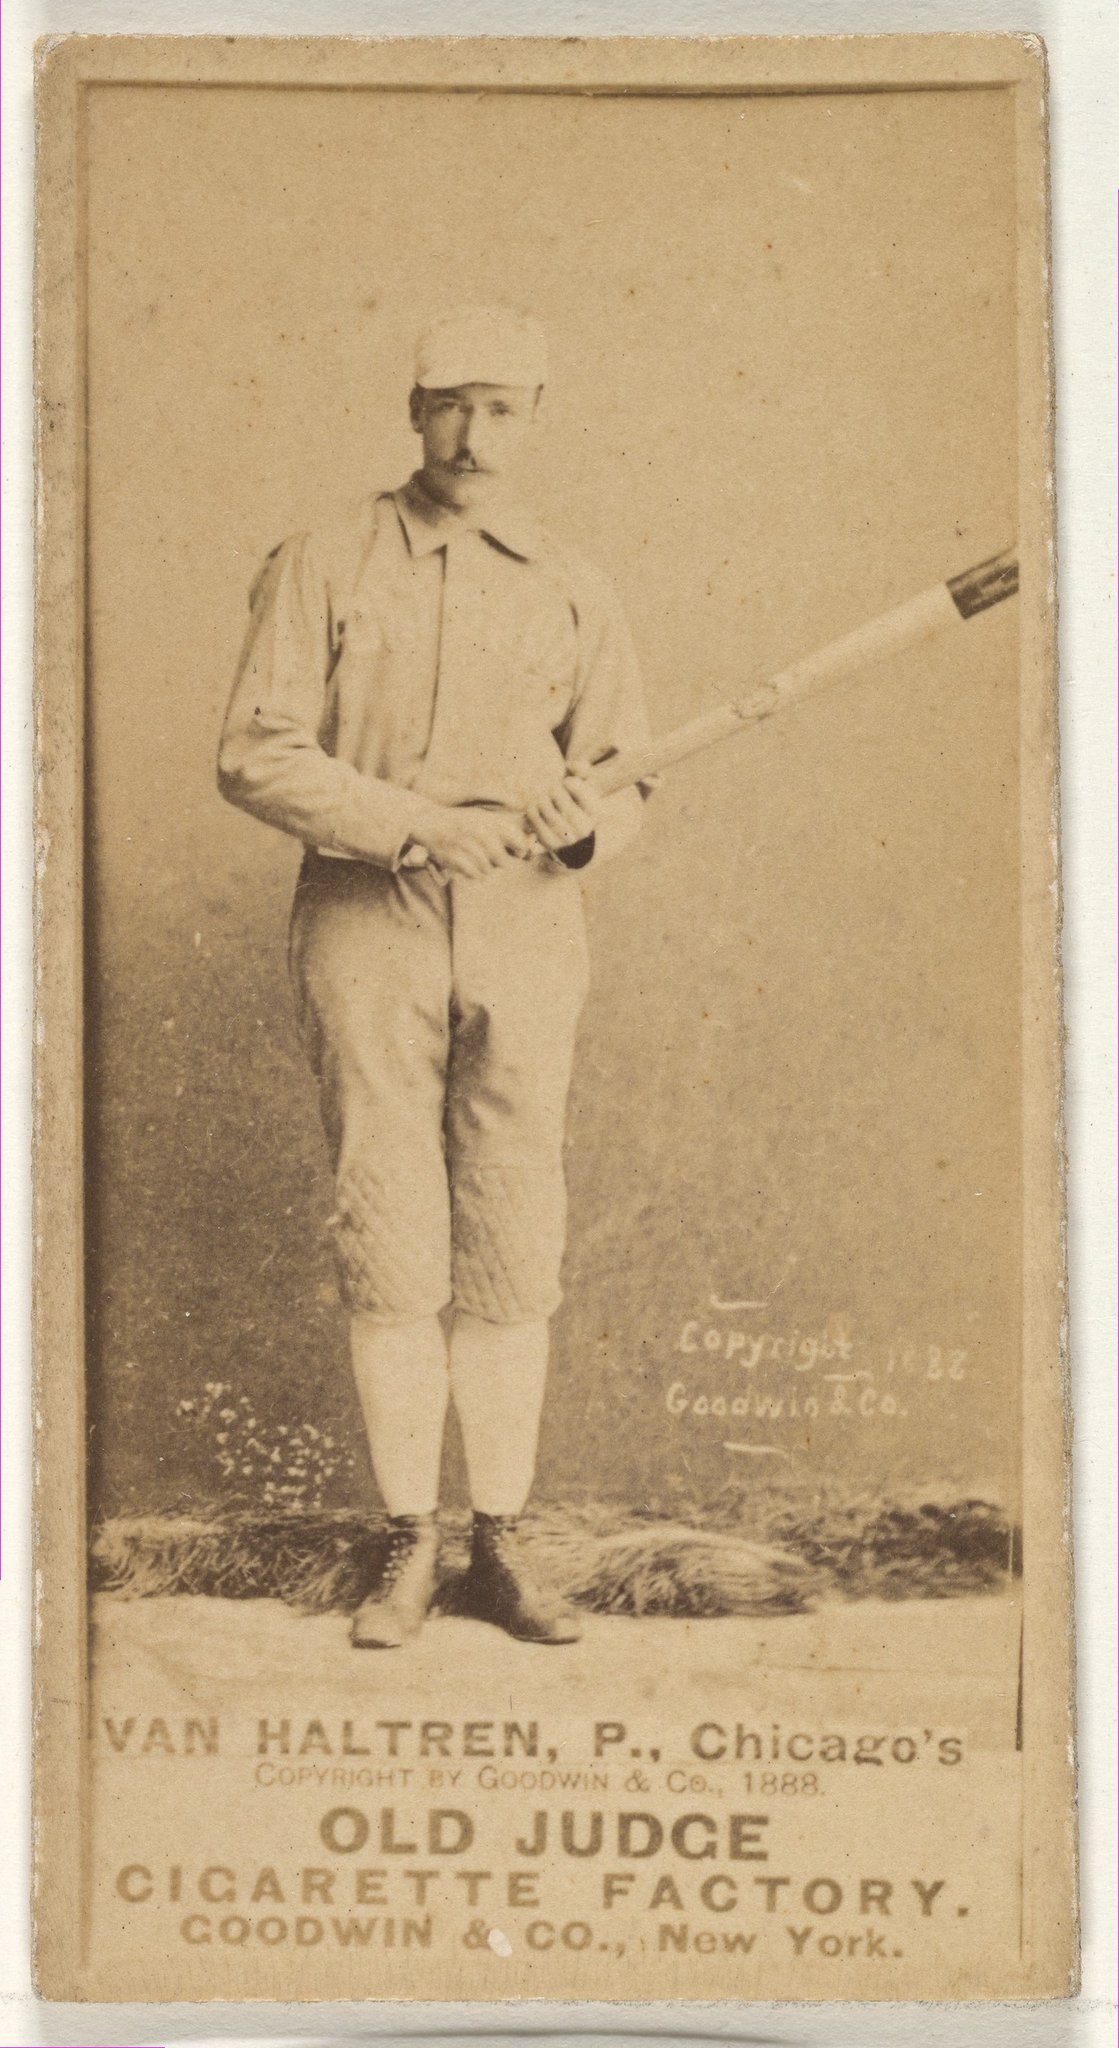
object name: baseball card, photograph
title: Van Haltren, Pitcher, Chicago, from the Old Judge series (N172) for Old Judge Cigarettes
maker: goodwin & company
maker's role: publisher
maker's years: 1850-1950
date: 1888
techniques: albumen silver print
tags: men,portraits,baseball,athletes